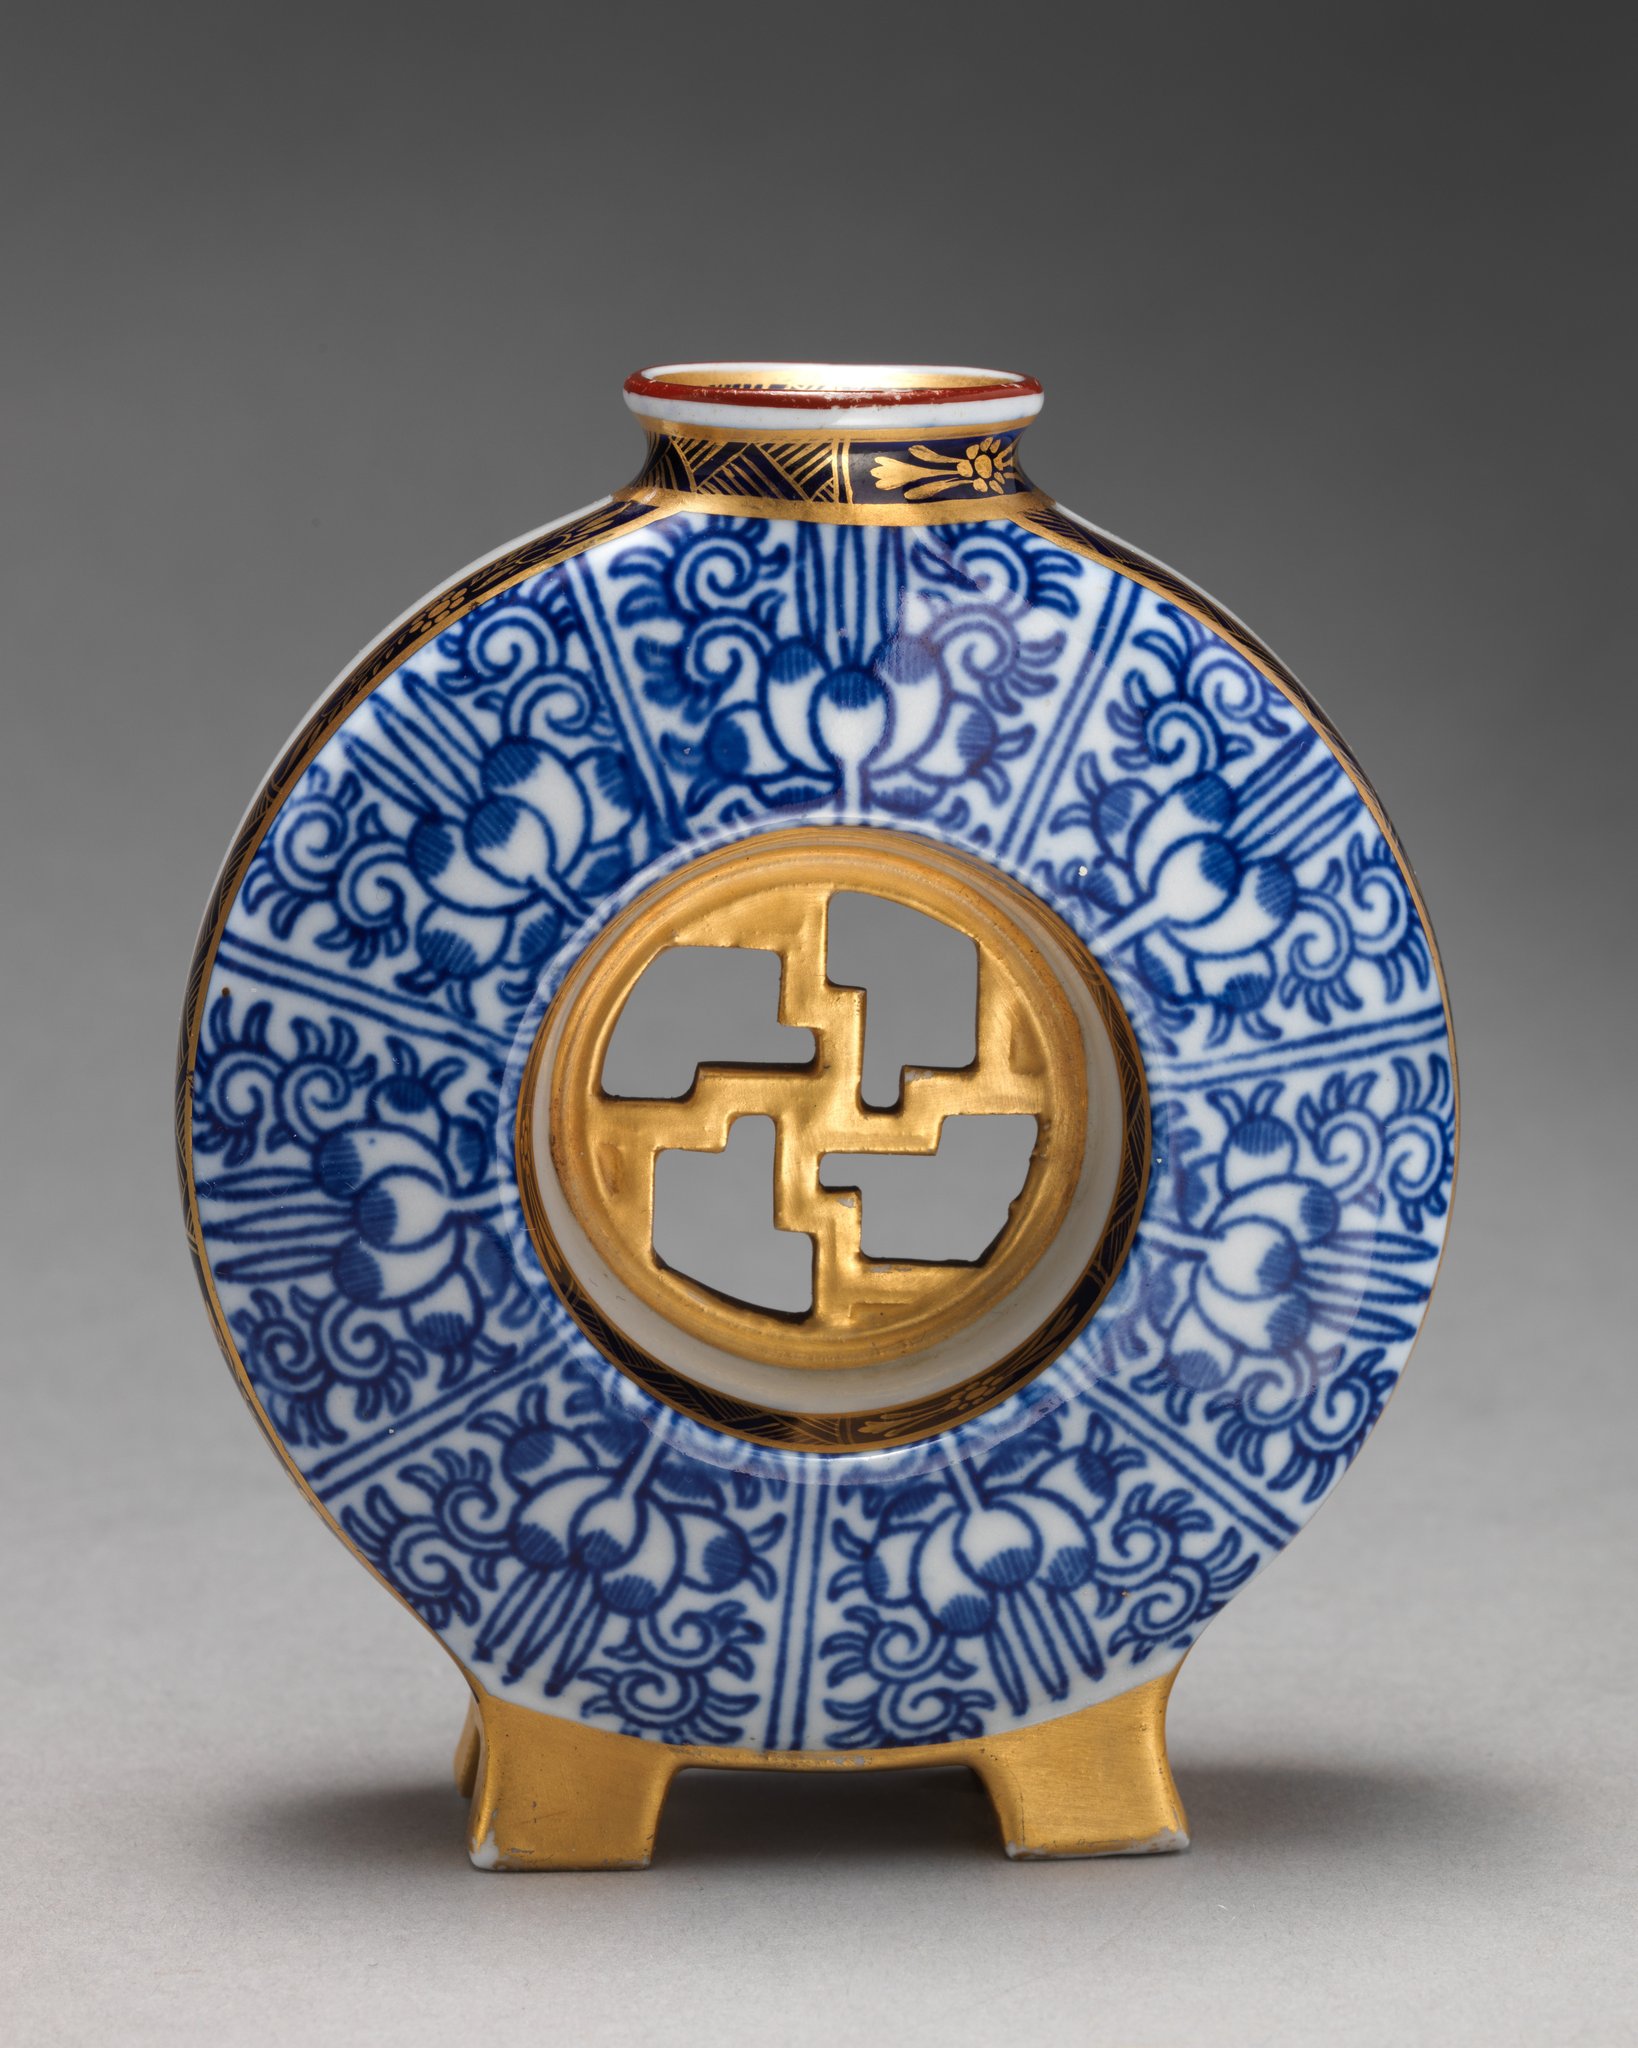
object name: miniature moon flask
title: Miniature moon flask with fretwork center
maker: worcester factory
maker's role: maker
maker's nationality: british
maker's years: 1751-2008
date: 1880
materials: bone china